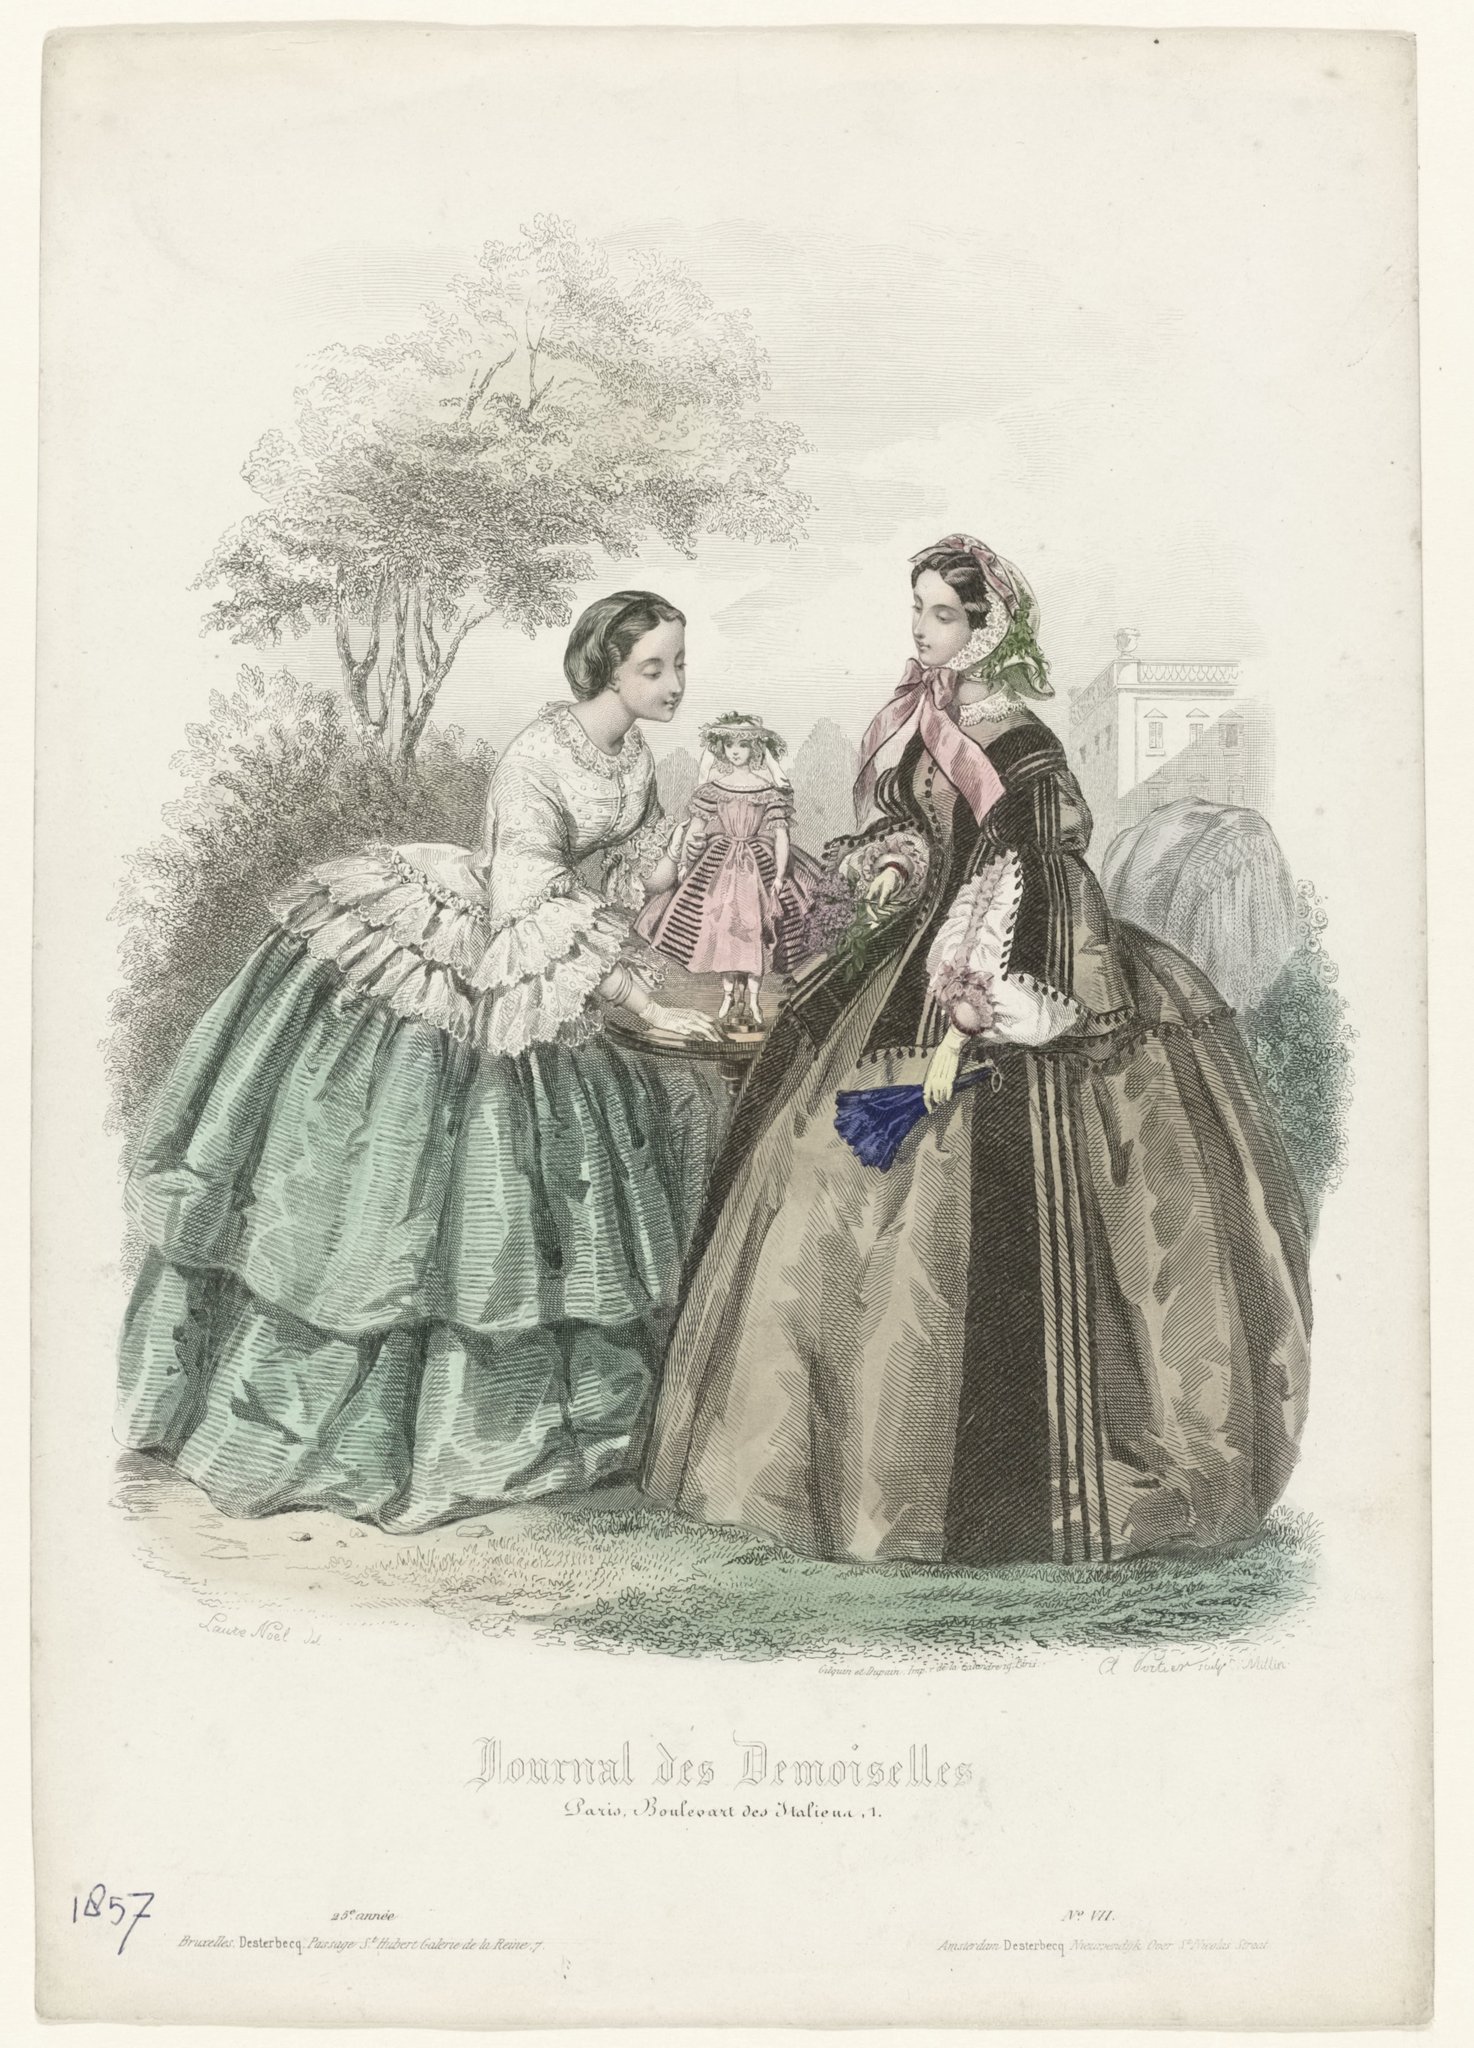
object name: fashion print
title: Journal des Demoiselles, 1857, 25e année, No. 7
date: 1857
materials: paper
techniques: engraving, hand coloring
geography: paris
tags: clothing for the upper part of the body (+ women's clothes), cut flowers; nosegay, bunch of flowers, gloves, mittens (short gloves) (+ women's clothes), skirt (crinoline skirt) (+ women's clothes), head-gear (fanchon) (+ women's clothes), dolls for adults, fashion plates, bracelet, wristlet (+ women's clothes)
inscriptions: address: ‘Paris, Boulevart des Italiens, 1.’, address: ‘Bruxelles Desterbecq Passage S.t Hubert Galerie de la Reine 7 / Amsterdam Desterbecq Nieuwendijk Over St Nicolas Straat’, title: ‘Journal des Demoiselles’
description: Twee vrouwen bij een tuintafel waarop een modepop. Links: gestippeld lijfje met wijd uitlopende mouwen op een wijde gestreepte rok. Rechts: tweedelige japon met streepmotief. Poffende ondermouwen. Accessoires: fanchon, armbanden, korte handschoenen, waaier(?). Prent uit het modetijdschrift Journal des Demoiselles (1833 -1922).